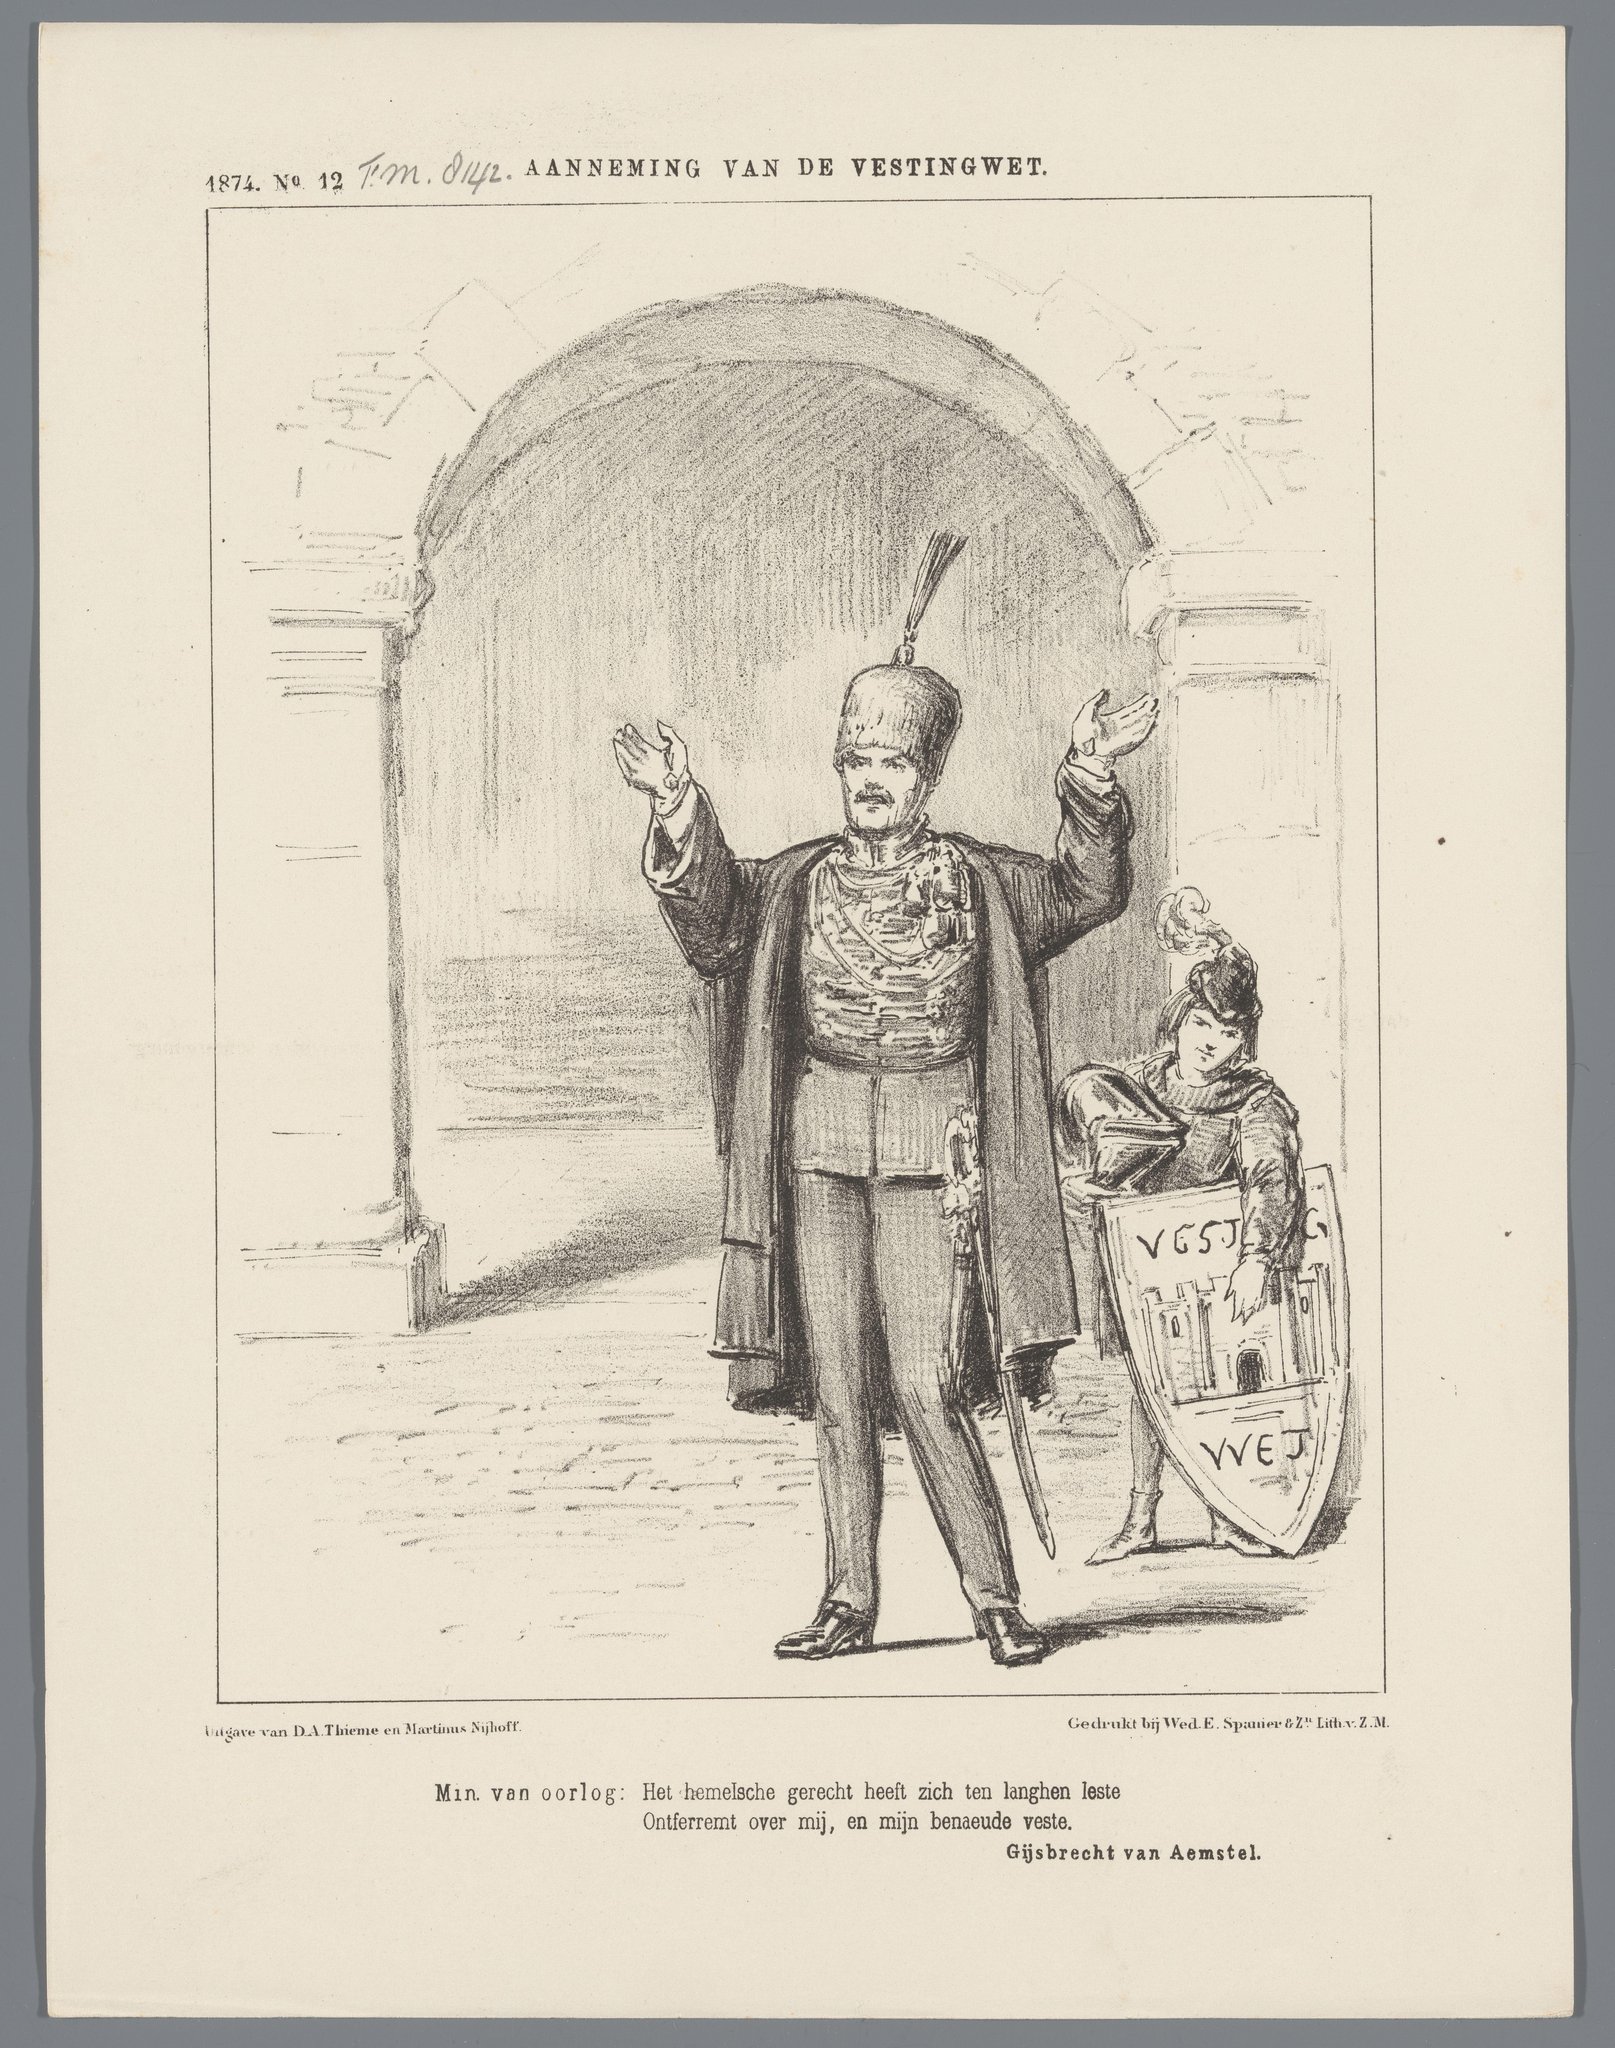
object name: print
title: Spotprent op de aanneming van de vestingwet, 1874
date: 1874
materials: paper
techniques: lithograph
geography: the hague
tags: (vondel, gijsbrecht van aemstel) specific works of literature (with author, title), amsterdam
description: Spotprent op de aanneming van de vestingwet met generaal Weitzel als Gijsbrecht van Amstel. Spotprent op de. Plaat verschenen bij het weekblad De Nederlandsche Spectator, nr. 12, 1874.